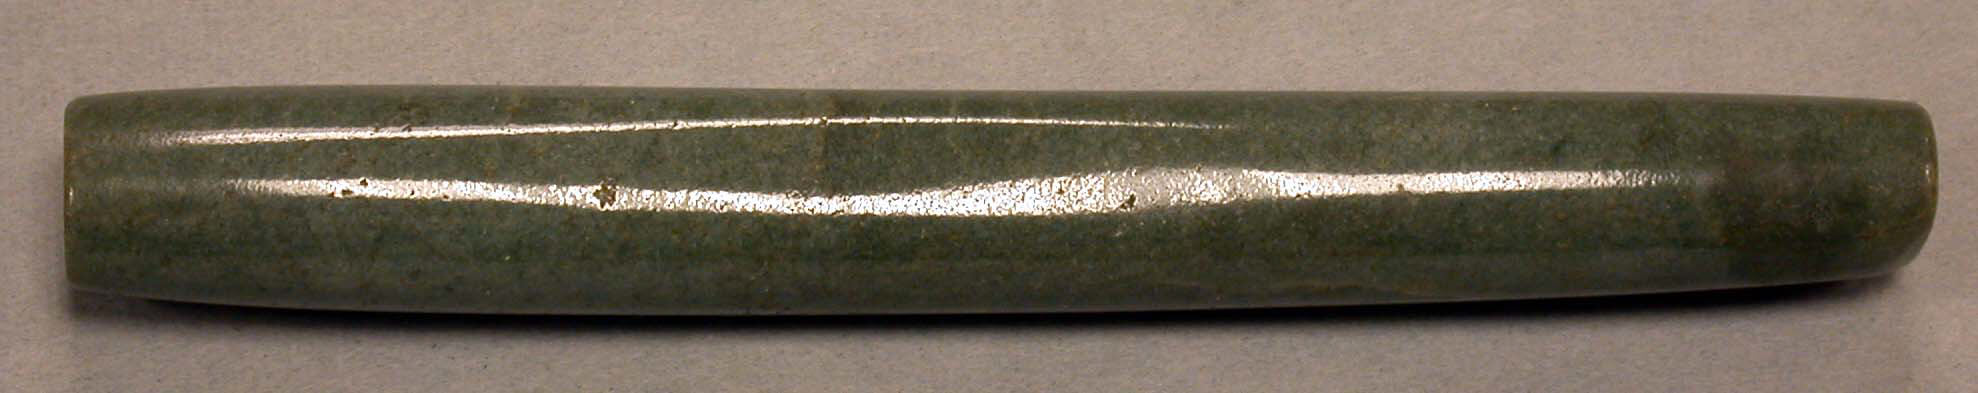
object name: bead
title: Tubular Stone Bead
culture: mexican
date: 1501-1600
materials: stone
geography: mexico